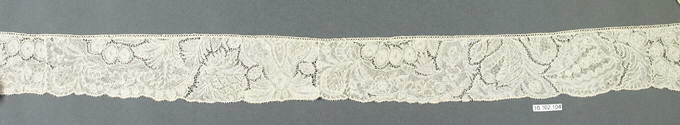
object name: fragment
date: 1701-1733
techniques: lace